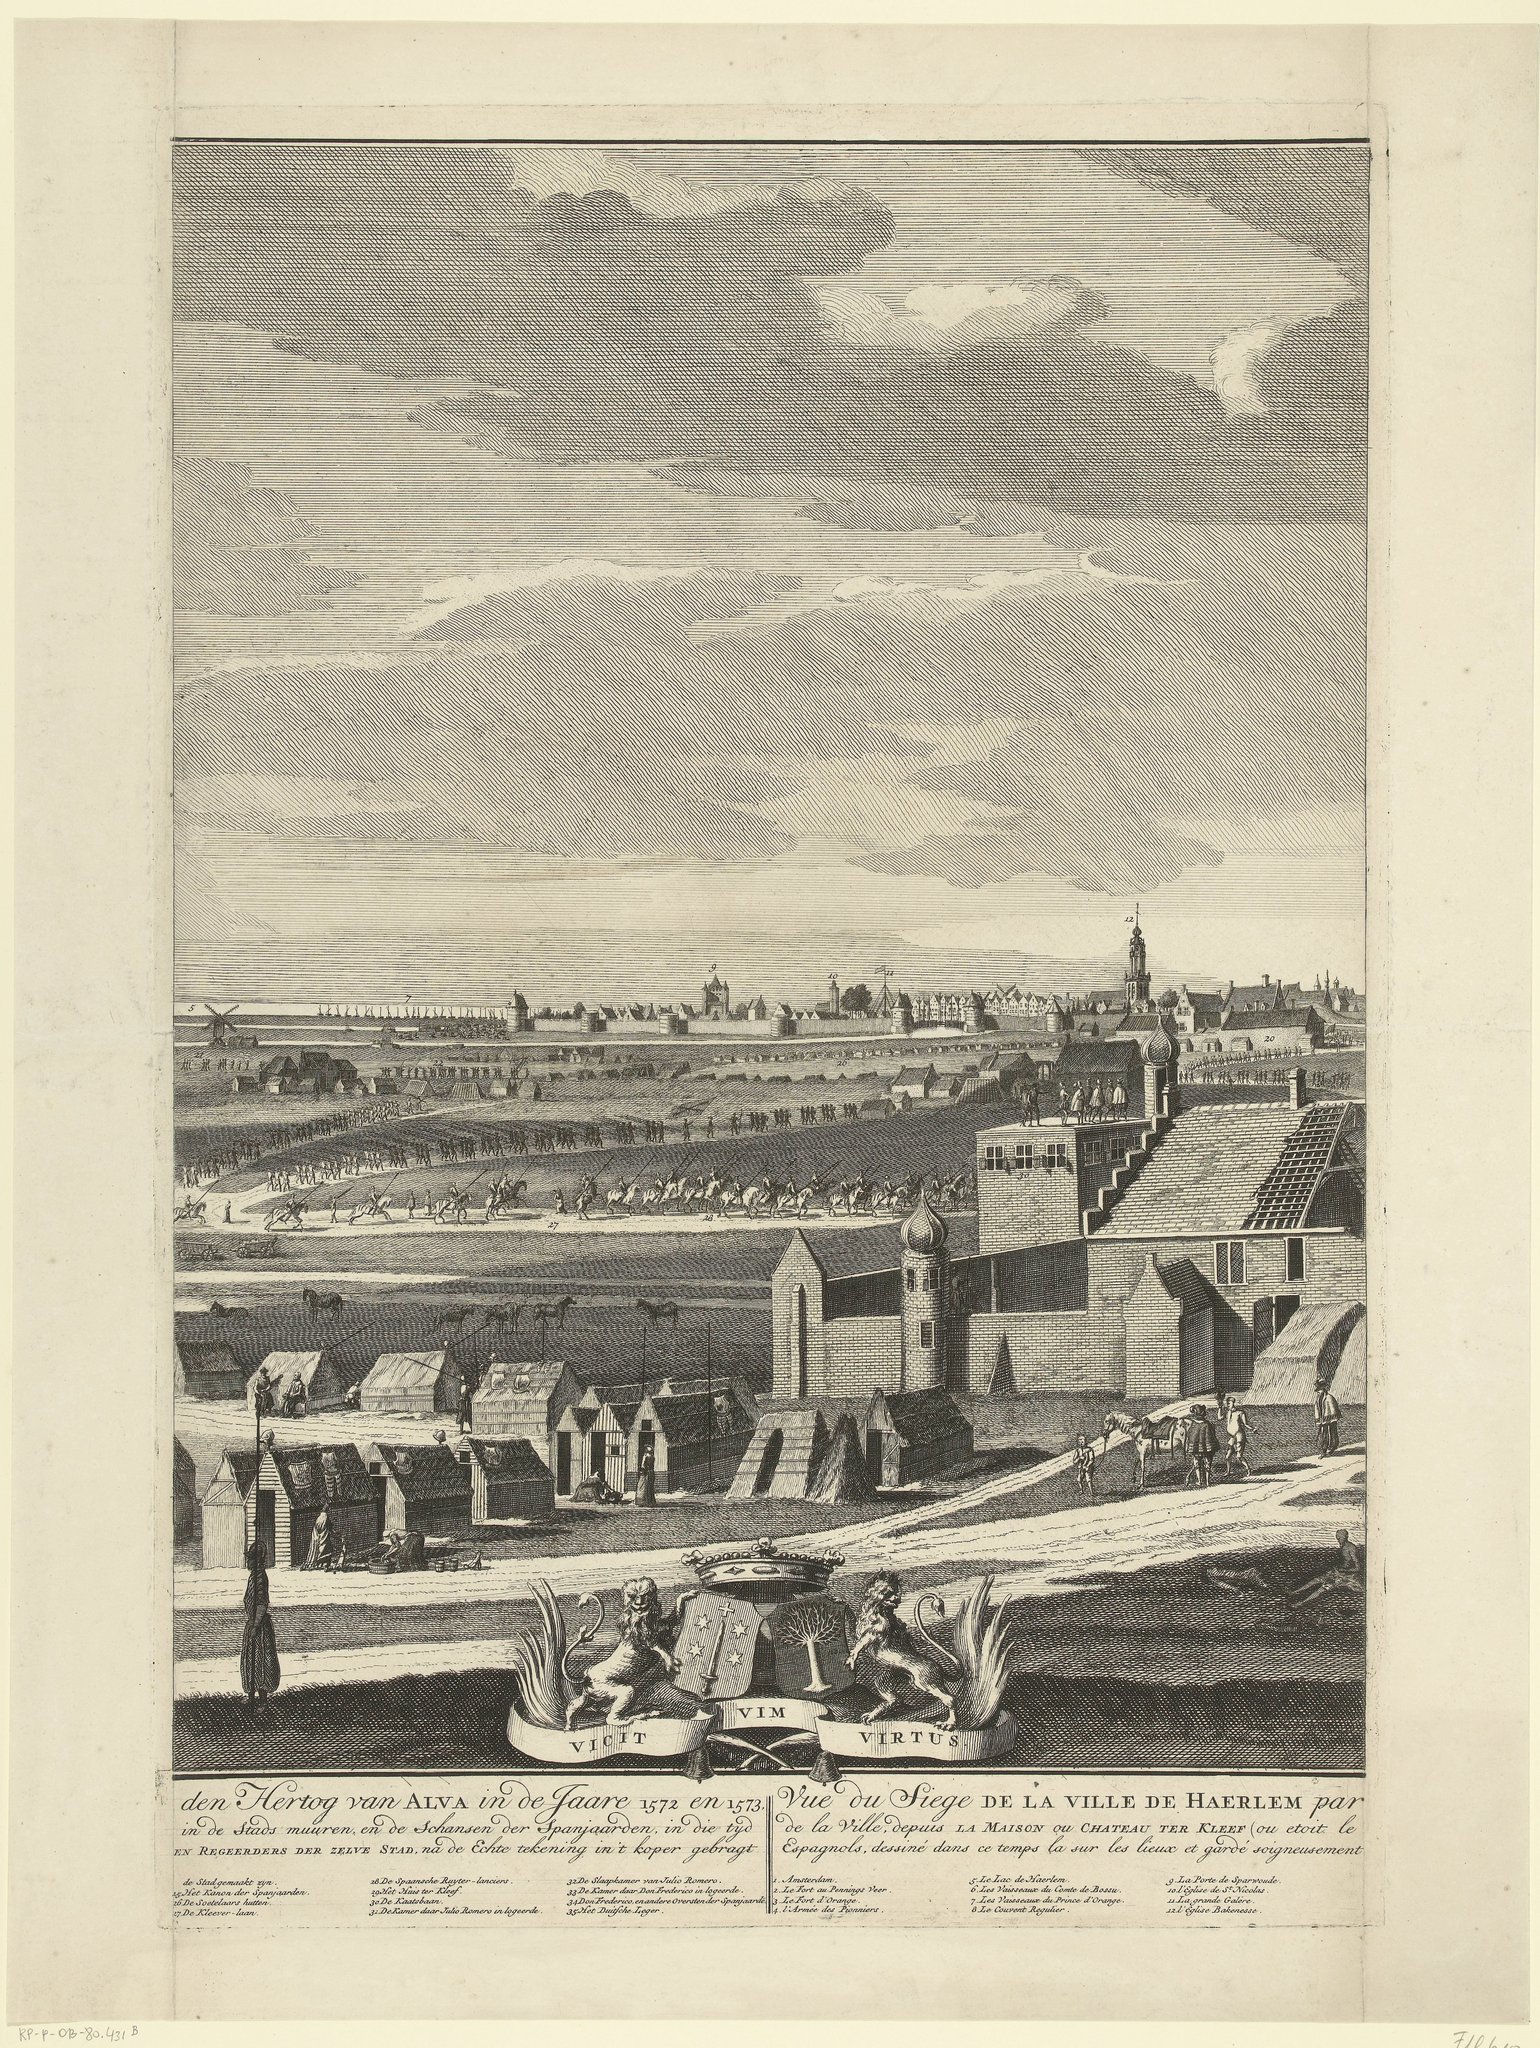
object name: print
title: Beleg van Haarlem, 1572-1573 (middenblad)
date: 1742-1779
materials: paper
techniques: etching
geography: haarlem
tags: siege, position war, haarlem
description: Belegering van de stad Haarlem in de jaren 1572-1573 door de Spanjaarden onder Fadrique Alvarez de Toledo (Don Frederik), de zoon van de hertog van Alva. Grote voorstelling met een gezicht op de stad vanuit het noorden, in prent naar een eigentijdse tekening in drie bladen, waarvan dit het middenblad is. Onder in het midden het wapen van Haarlem. Onder de voorstelling de titels en de legenda's 1-35 in het Nederlands en Frans.